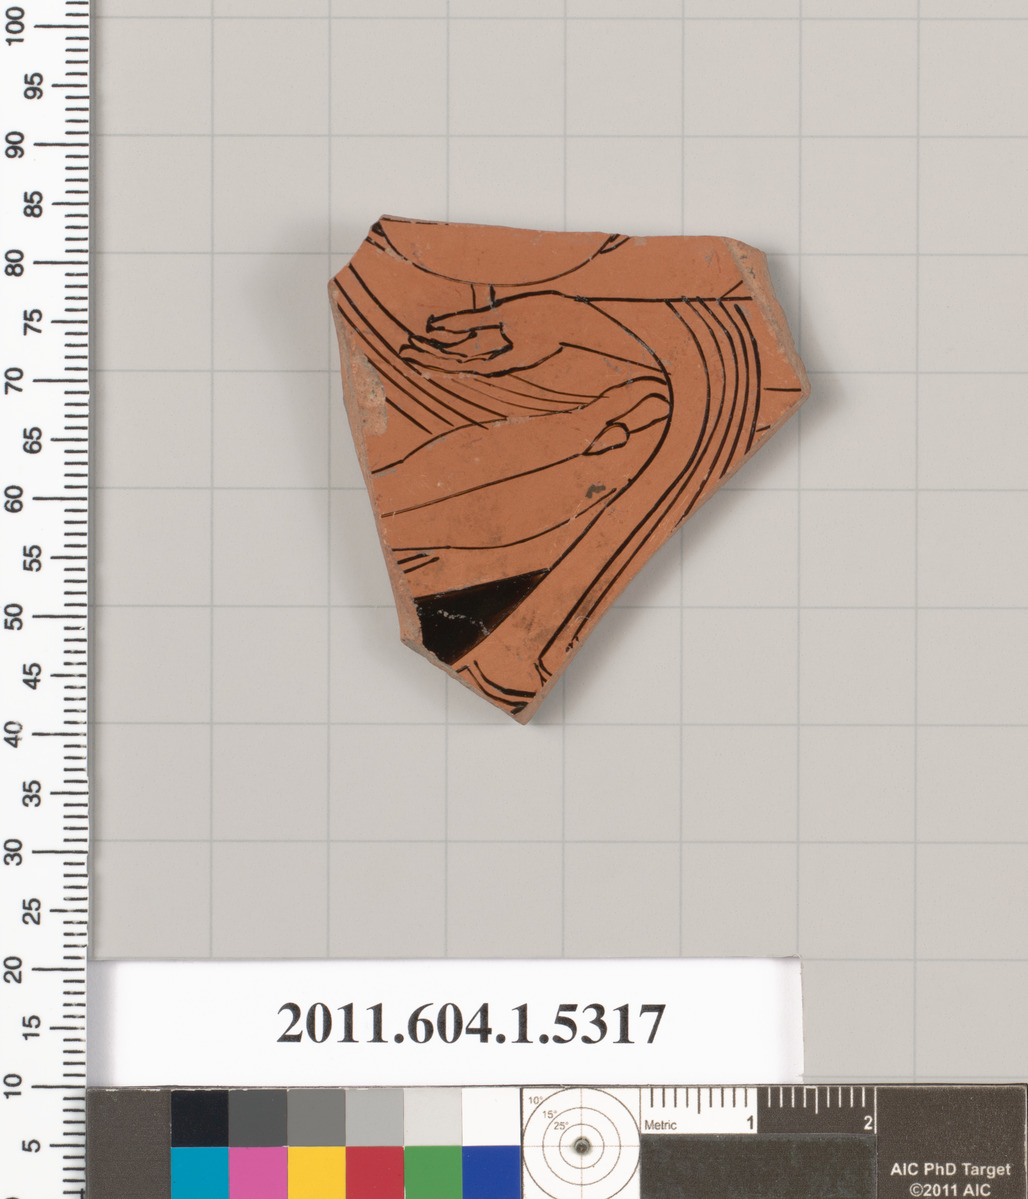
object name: kylix fragment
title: Terracotta fragment of a kylix (drinking cup)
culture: greek, attic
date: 500-480 BCE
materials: terracotta